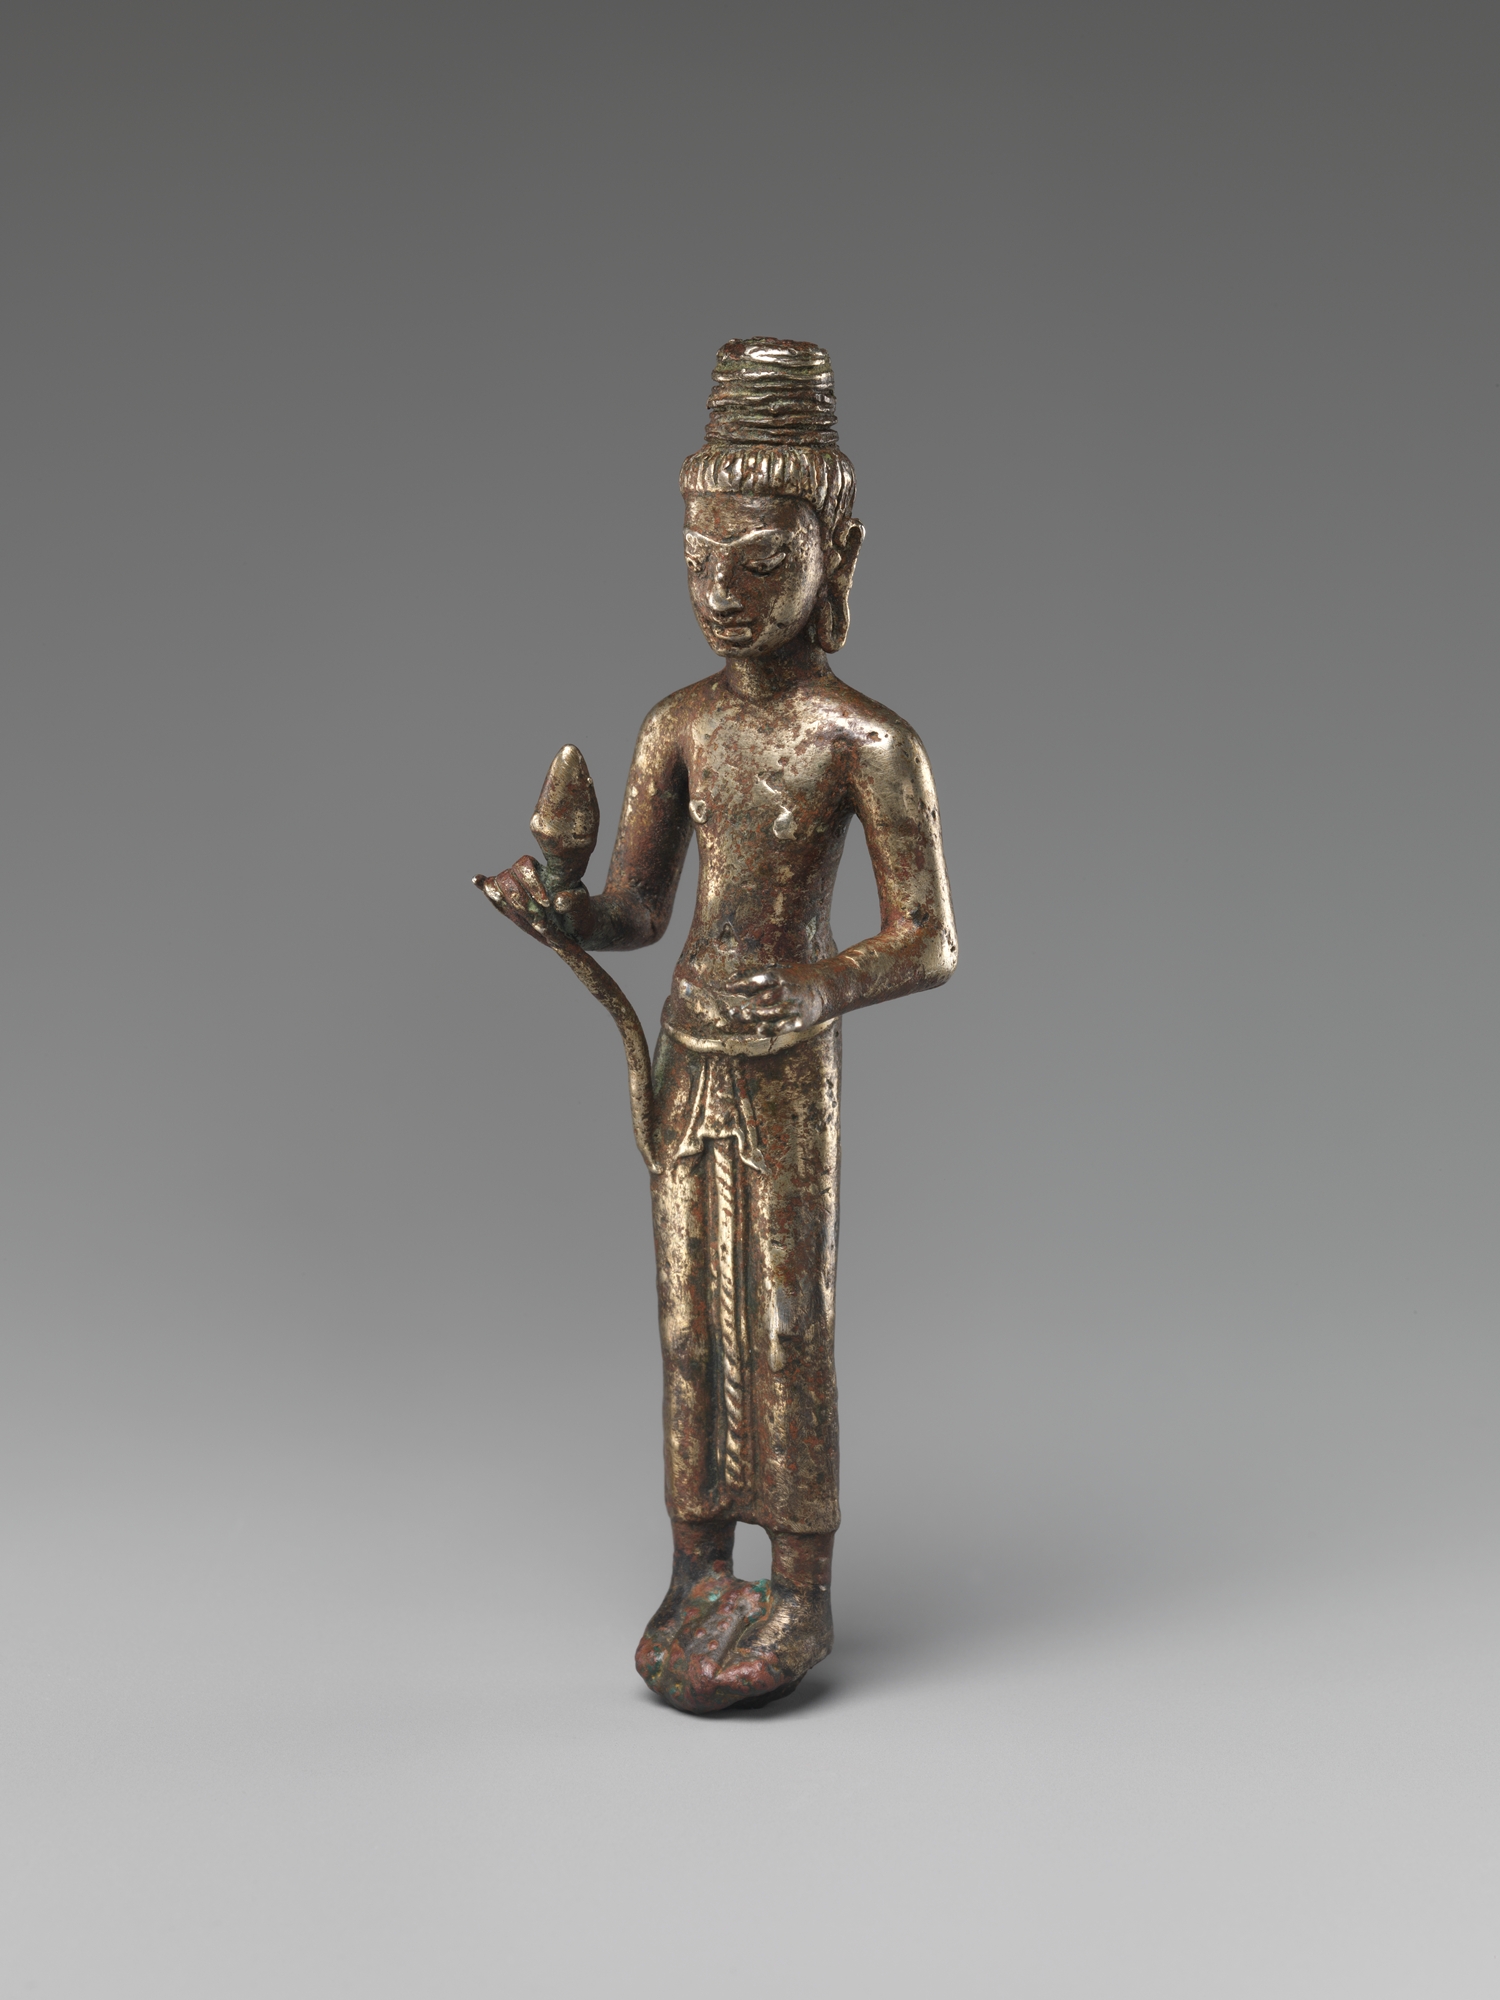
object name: figurine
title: Standing Bodhisattva, probably Maitreya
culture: northeast thai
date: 601-800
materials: alloy, silver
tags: buddhism,bodhisattvas,maitreya